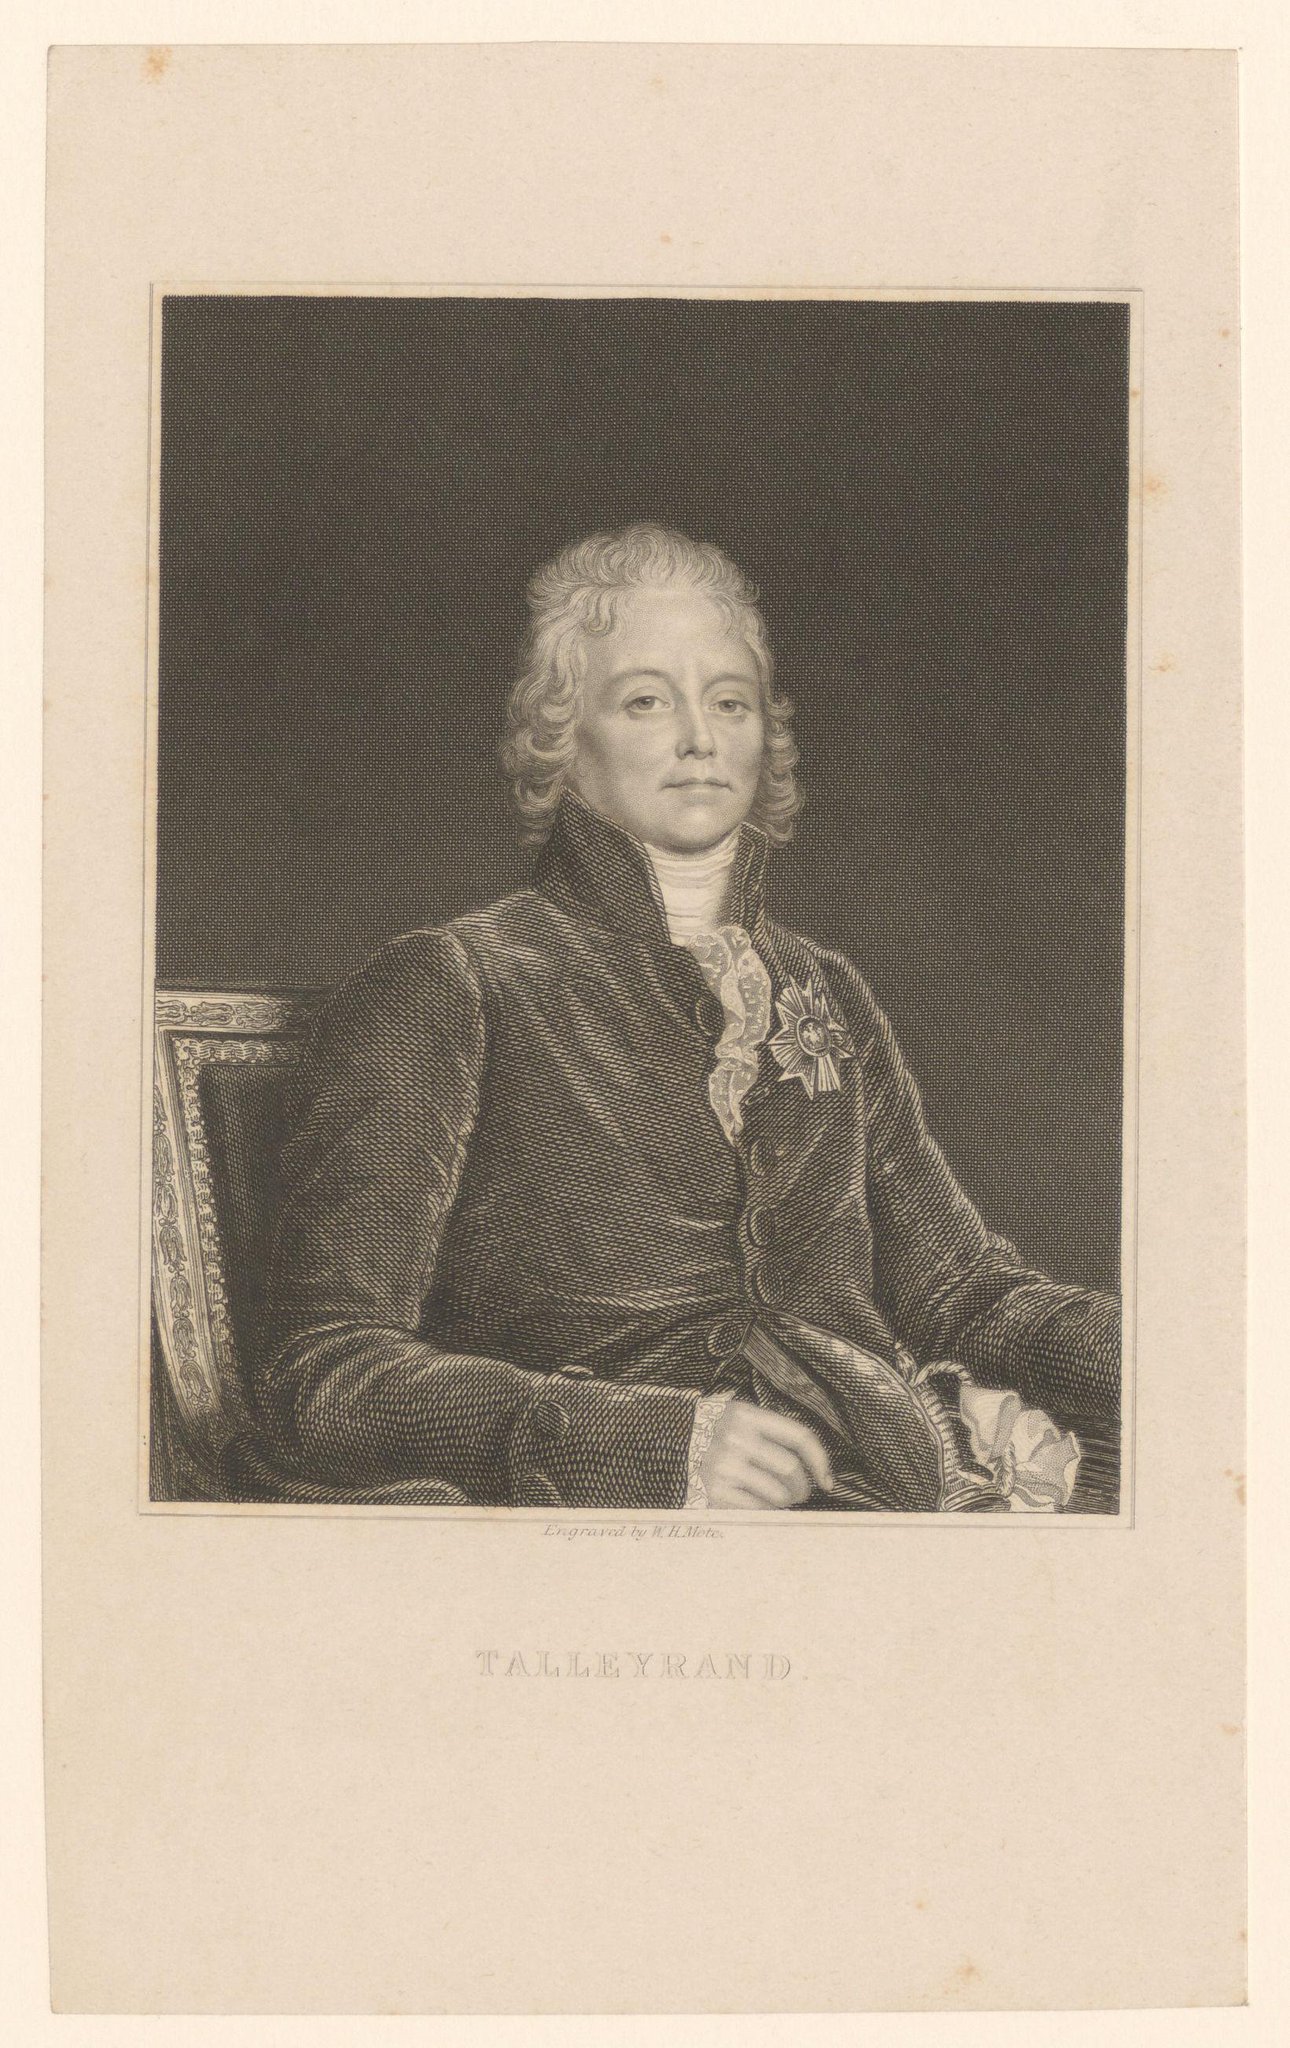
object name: print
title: Talleyrand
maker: william henry mote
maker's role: print maker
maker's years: 1803-1871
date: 1833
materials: paper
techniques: etching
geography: england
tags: politician, charles maurice hertog van talleyrand-périgord, historical persons, politician, e.g. party leader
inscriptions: collector's mark: Lugt 2228